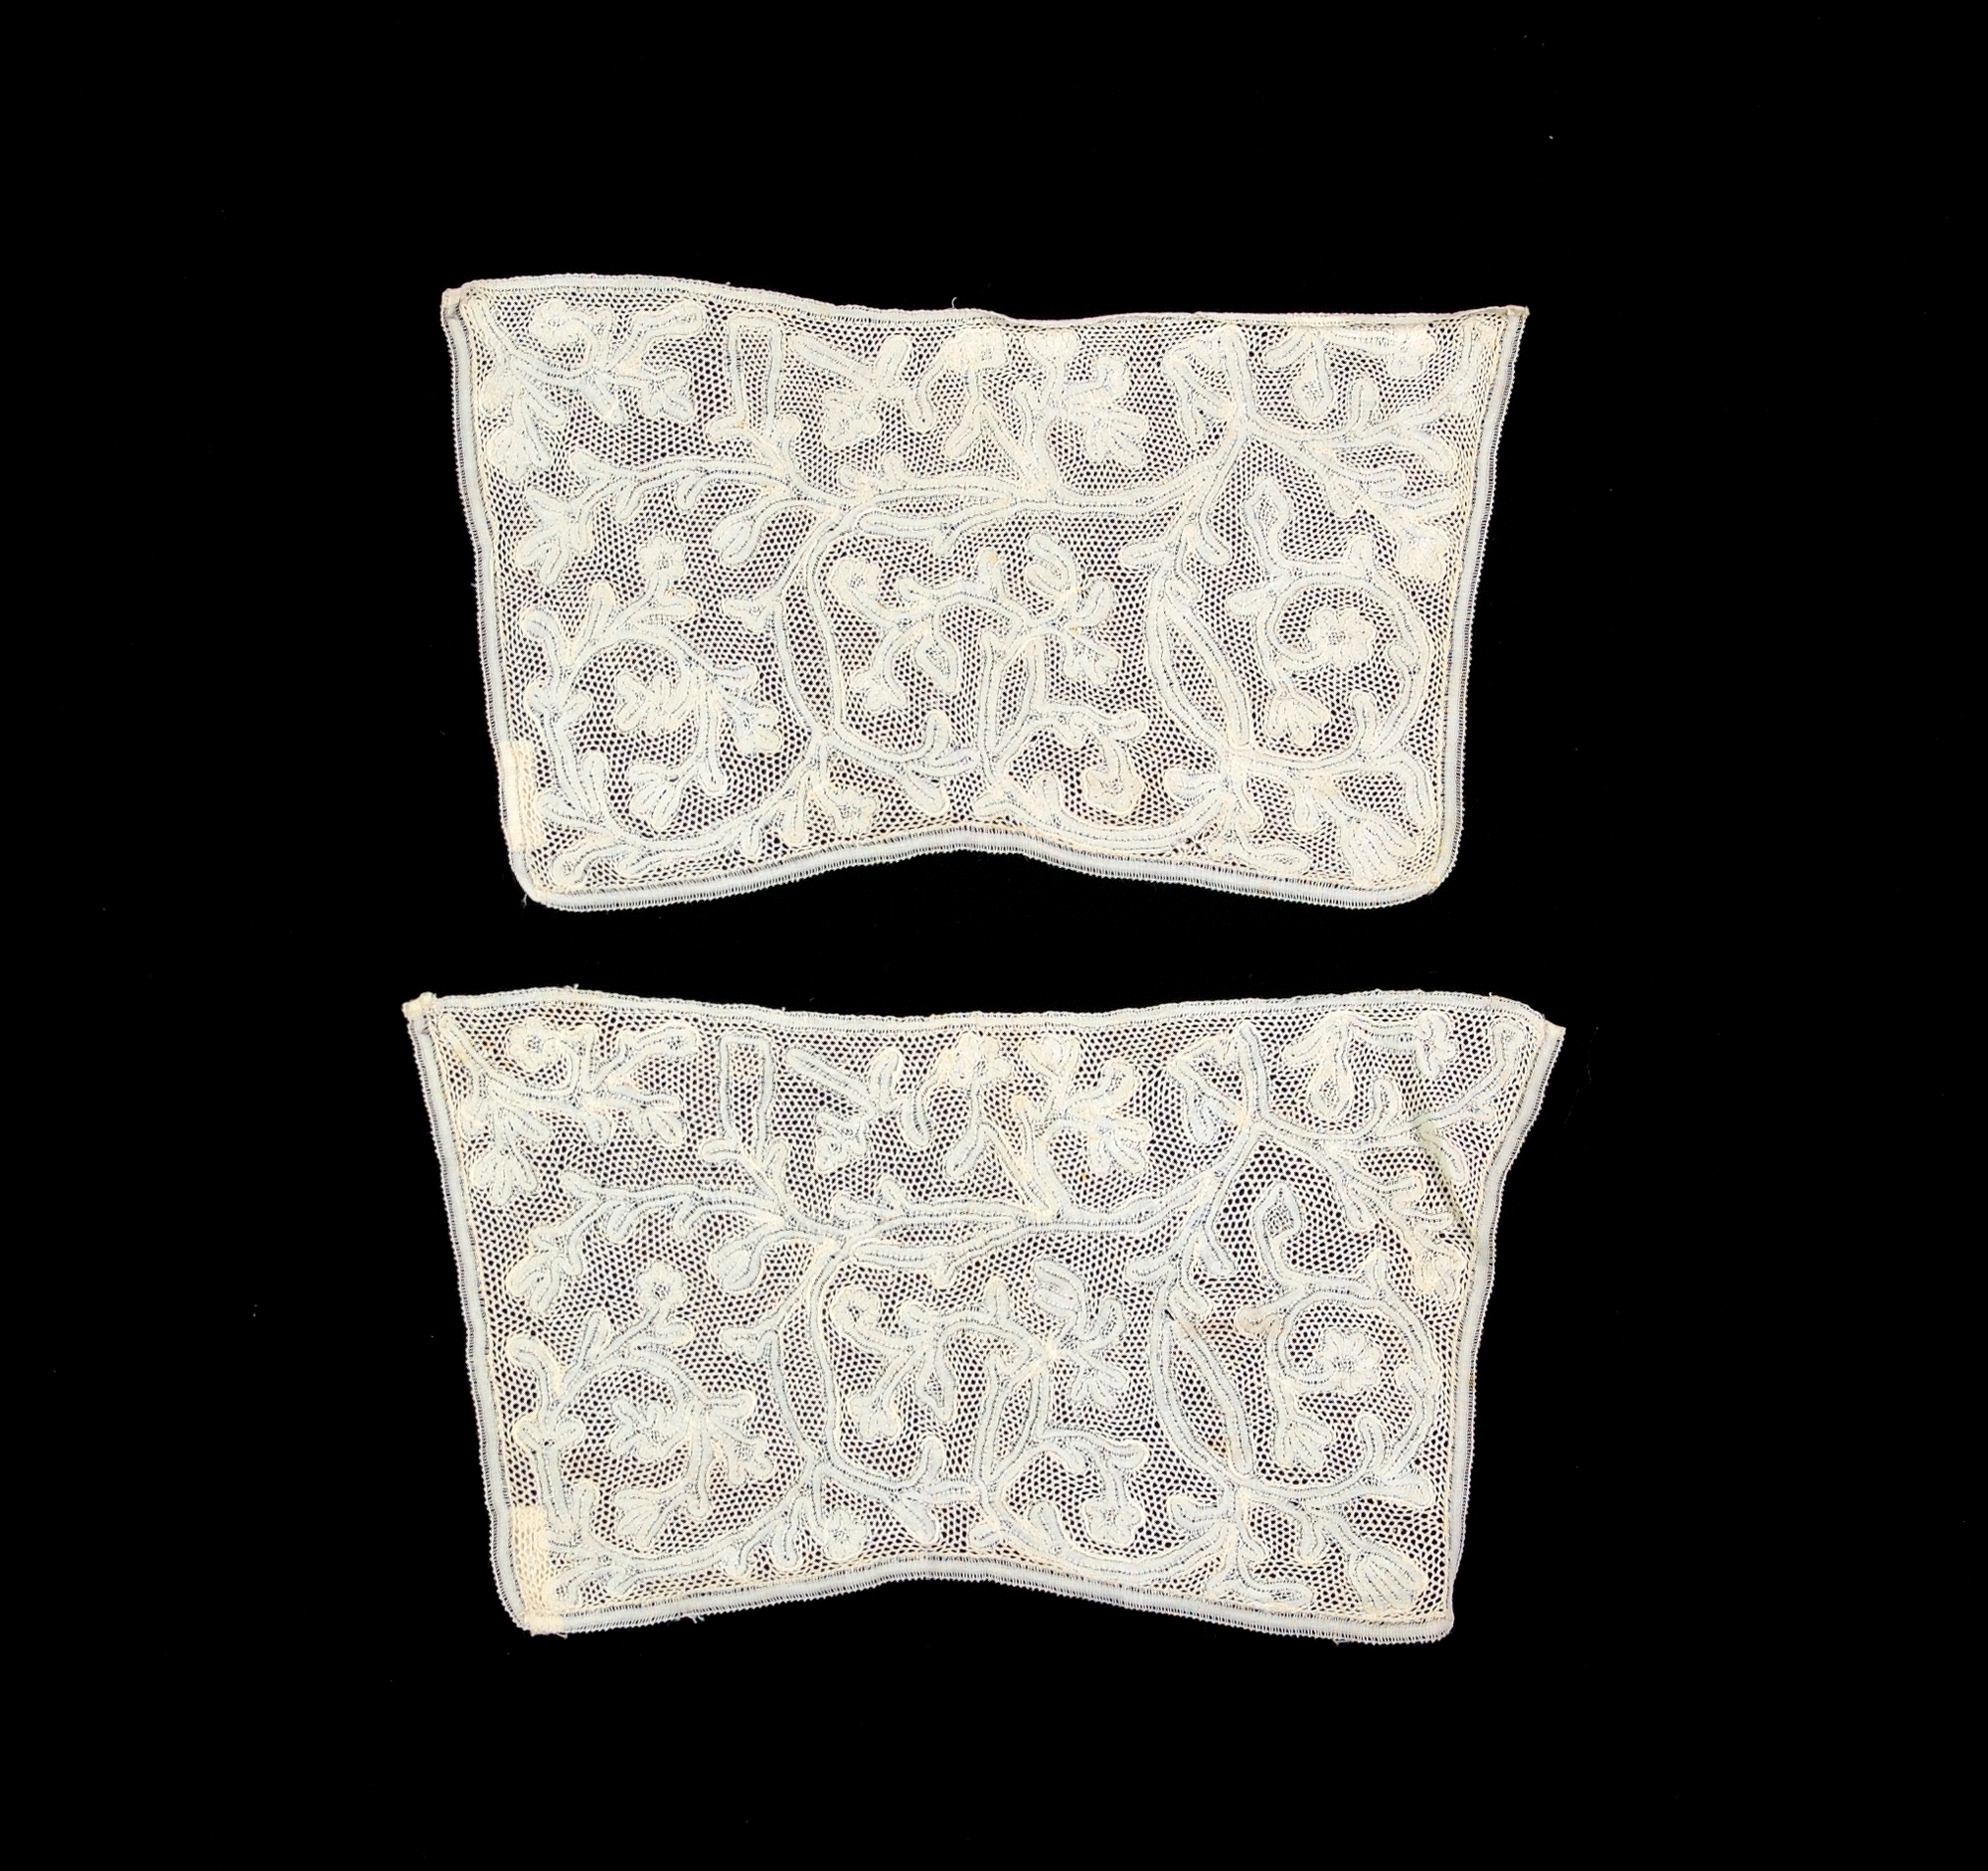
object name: cuff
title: Cuffs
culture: italian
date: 1667-1700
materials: linen